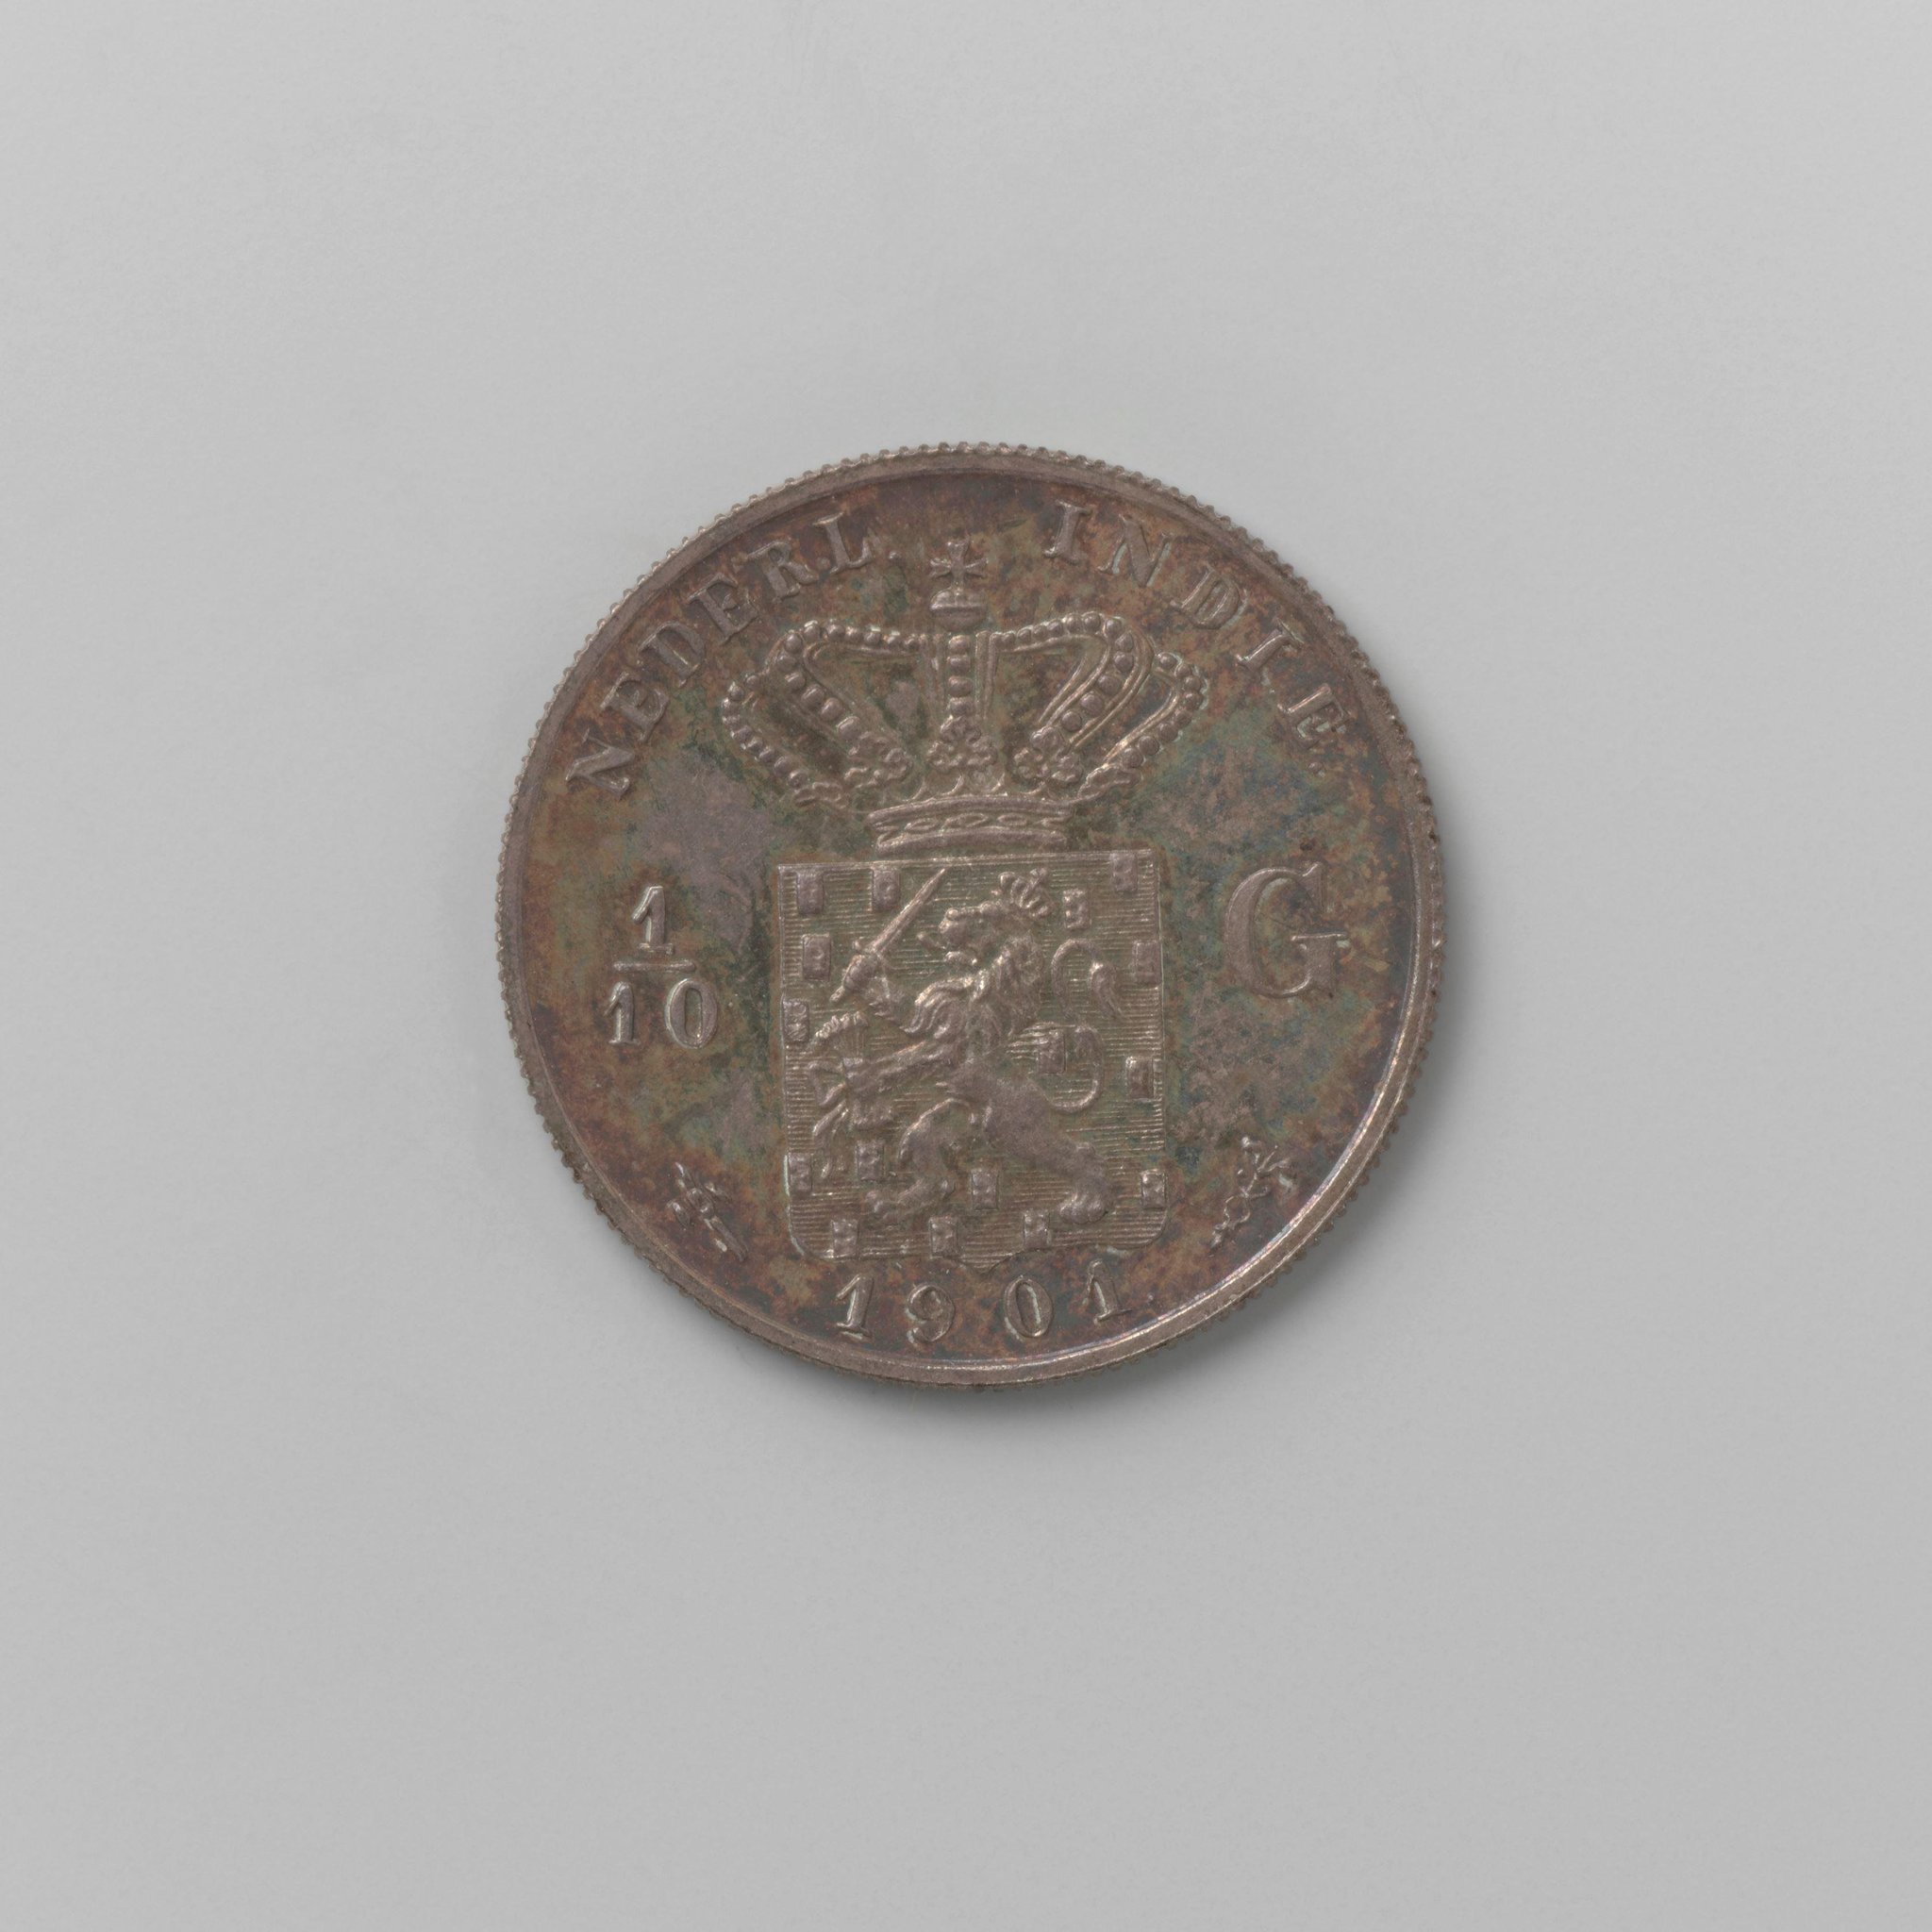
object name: coin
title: 1/10 gulden van Nederlands Indië,1901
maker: wilhelmina of the netherlands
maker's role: print maker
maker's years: 1880-1962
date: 1901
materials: copper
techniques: striking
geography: utrecht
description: Zilveren munt. Voorzijde: tussen waarde-aanduiding 1/10 G gekroond rijkswapenschild. Boven kroon landsaanduiding en onder wapenschild jaartal. Keerzijde: tweeregelig Maleis opschrift in Arabische tekens, waaromheen omschrift in het Javaans. Kartelrand.